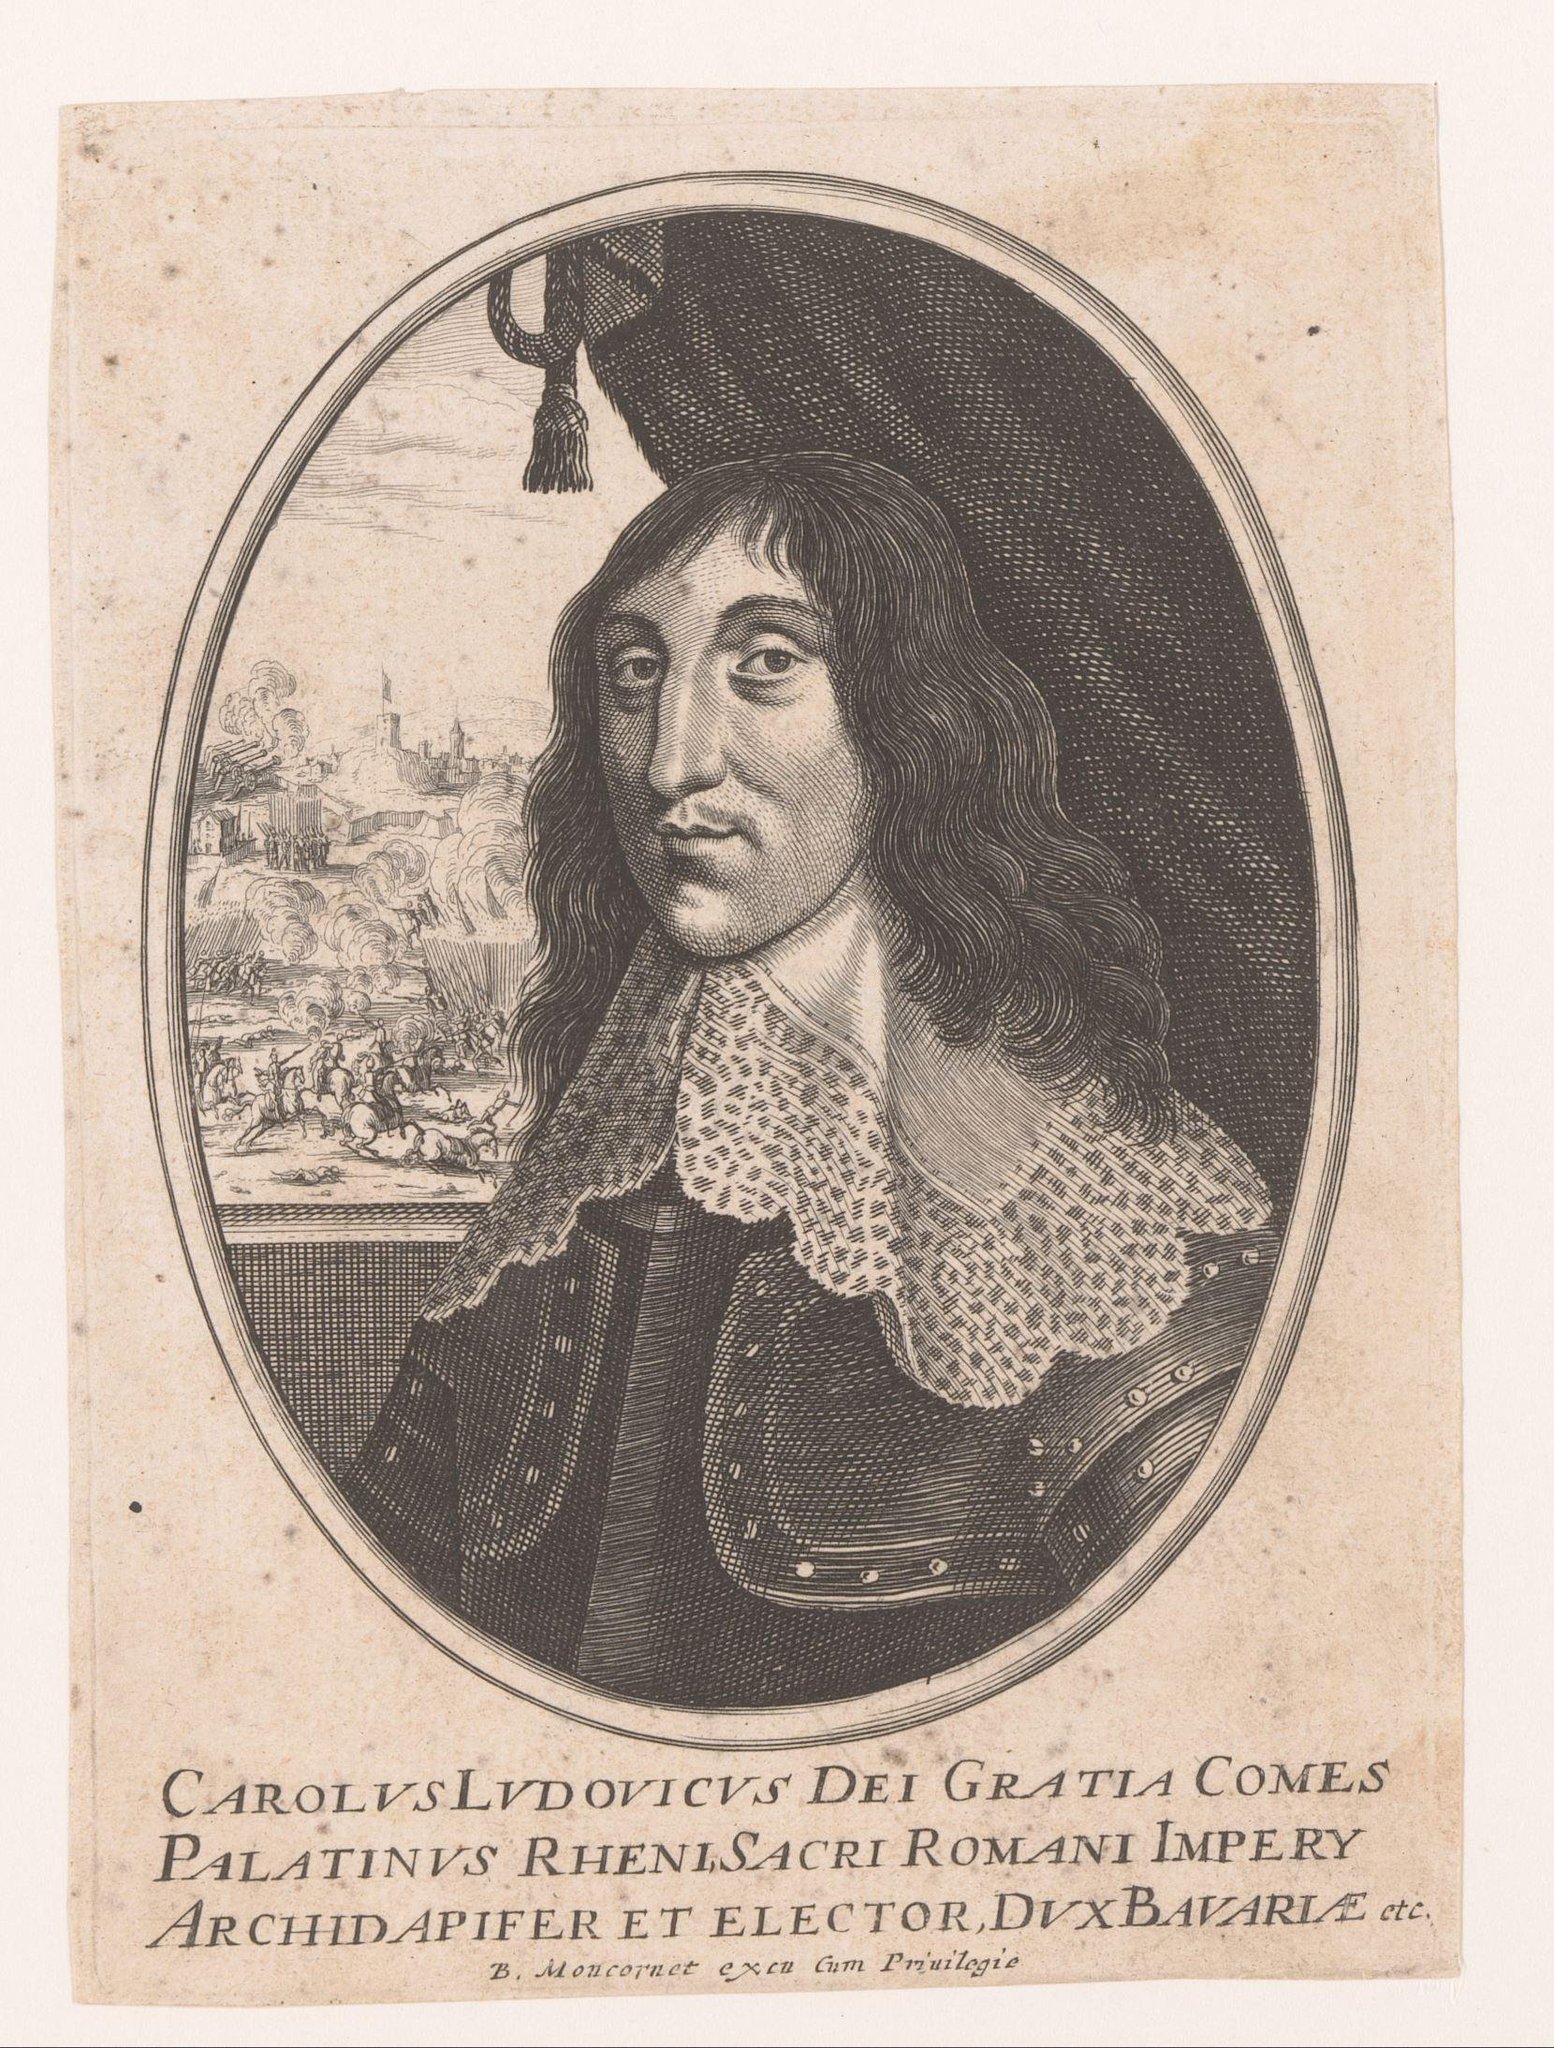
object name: print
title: Portret van Karel I Lodewijk van de Palts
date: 1635-1668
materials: paper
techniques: engraving, etching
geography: france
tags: historical persons, nobility and patriciate; chivalry, knighthood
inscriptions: collector's mark: Lugt 2228